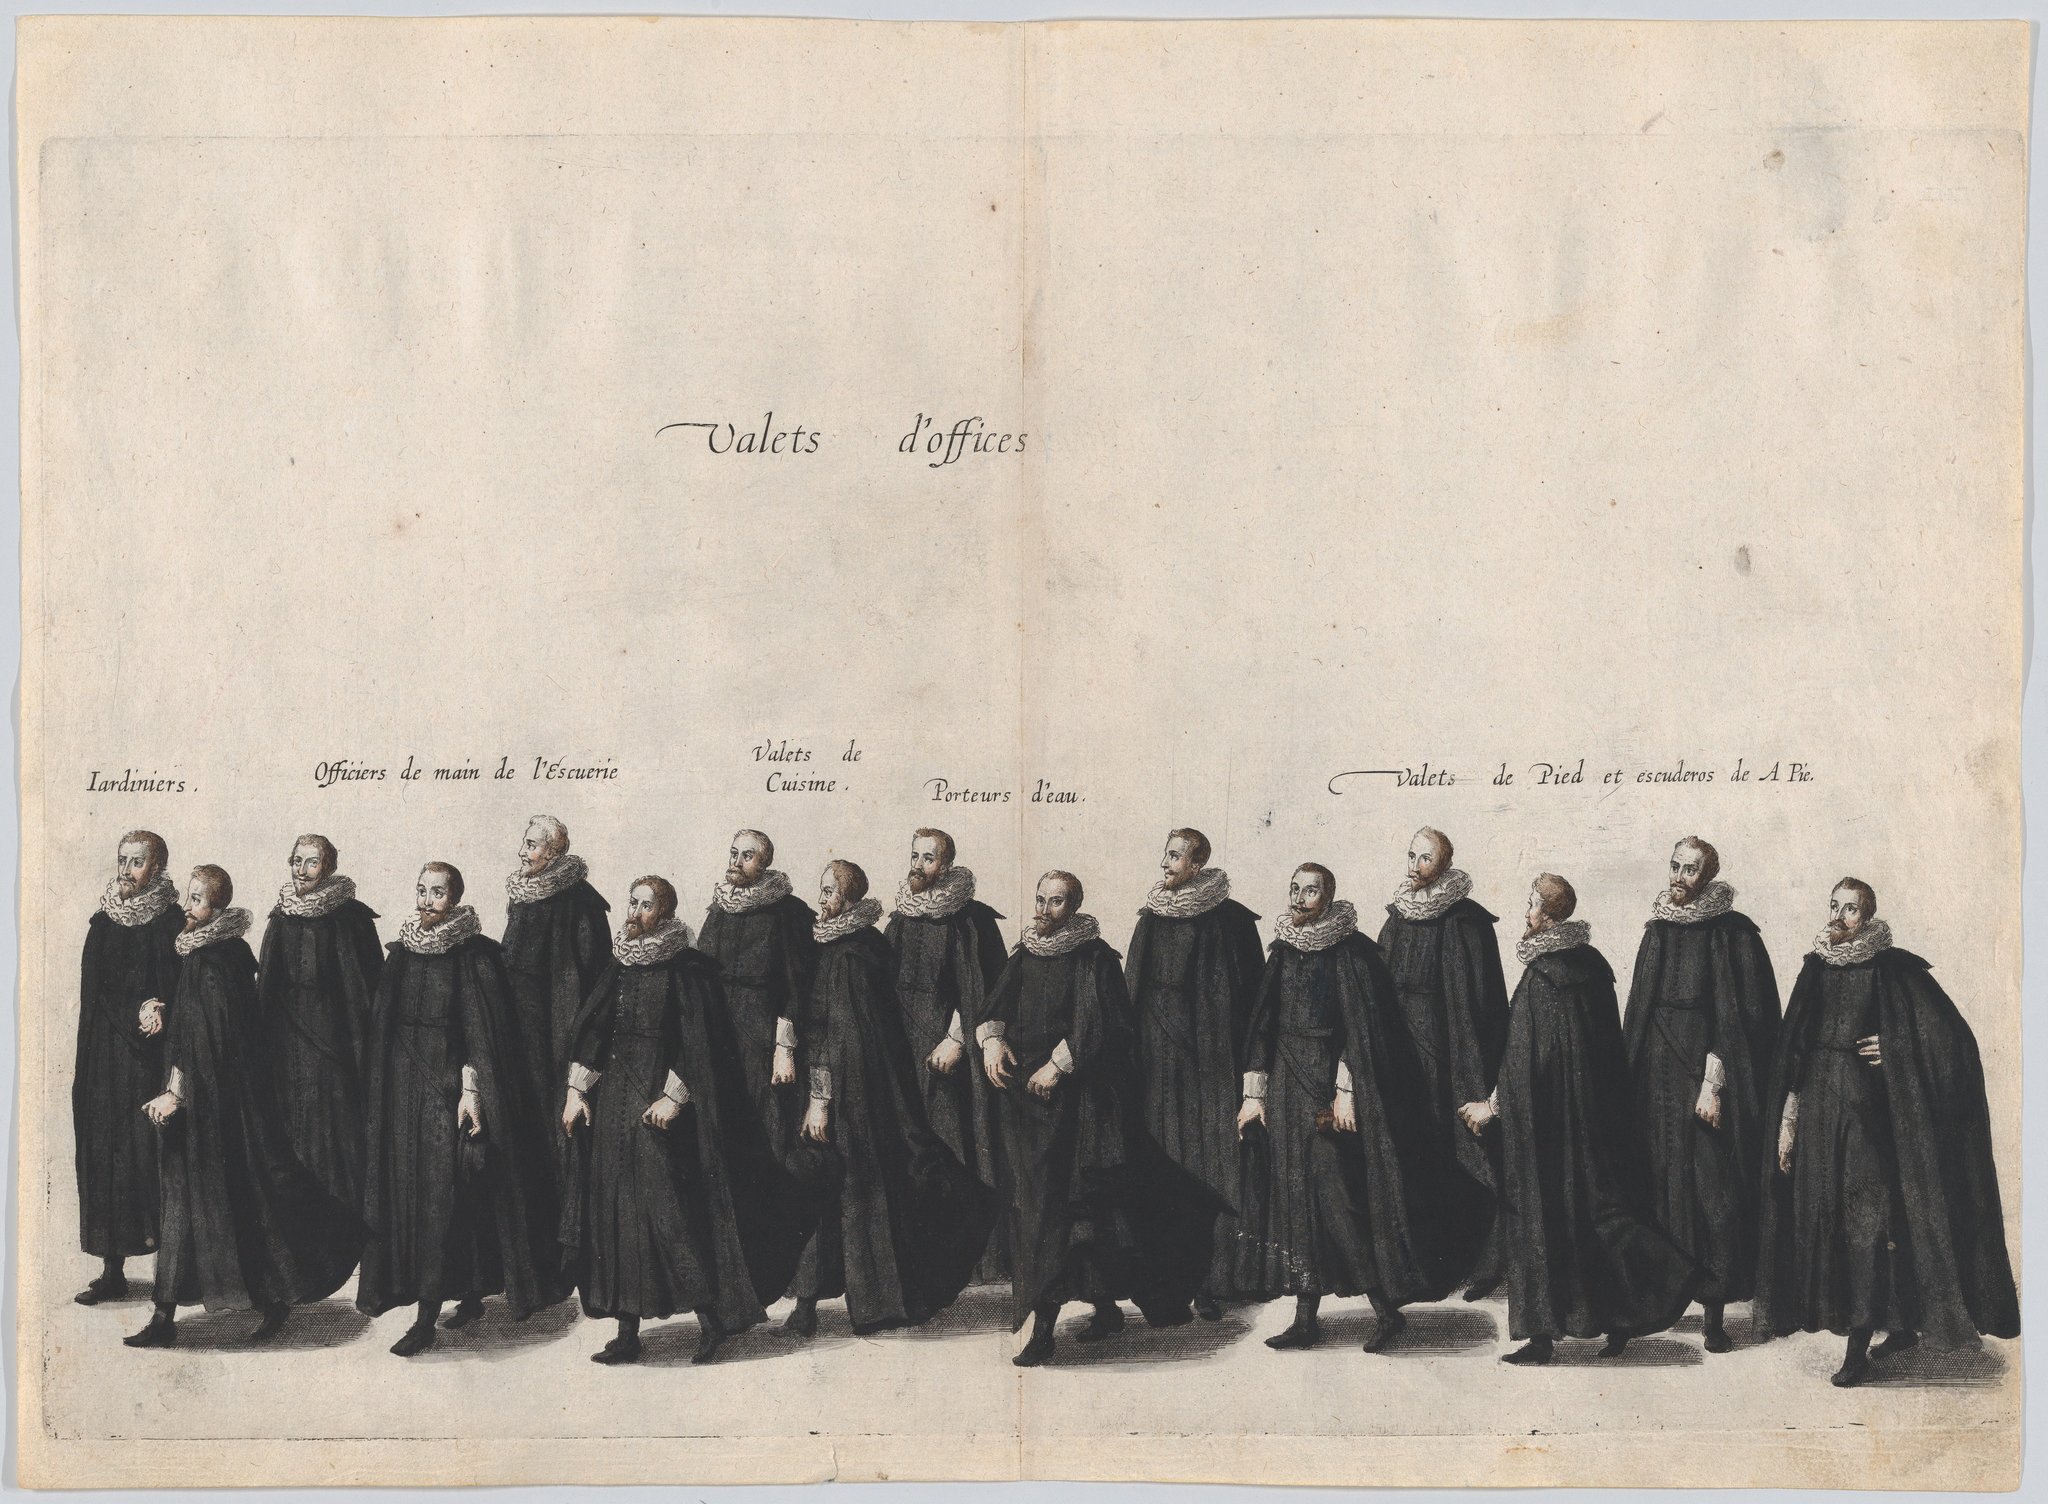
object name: print, fete, ornament architecture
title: Plate 14: Valets marching in the funeral procession of Archduke Albert of Austria; from 'Pompa Funebris ... Alberti Pii'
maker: cornelis galle (i)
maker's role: artist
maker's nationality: netherlandish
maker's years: 1576-1650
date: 1623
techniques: etching, hand coloring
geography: brussels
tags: men,walking